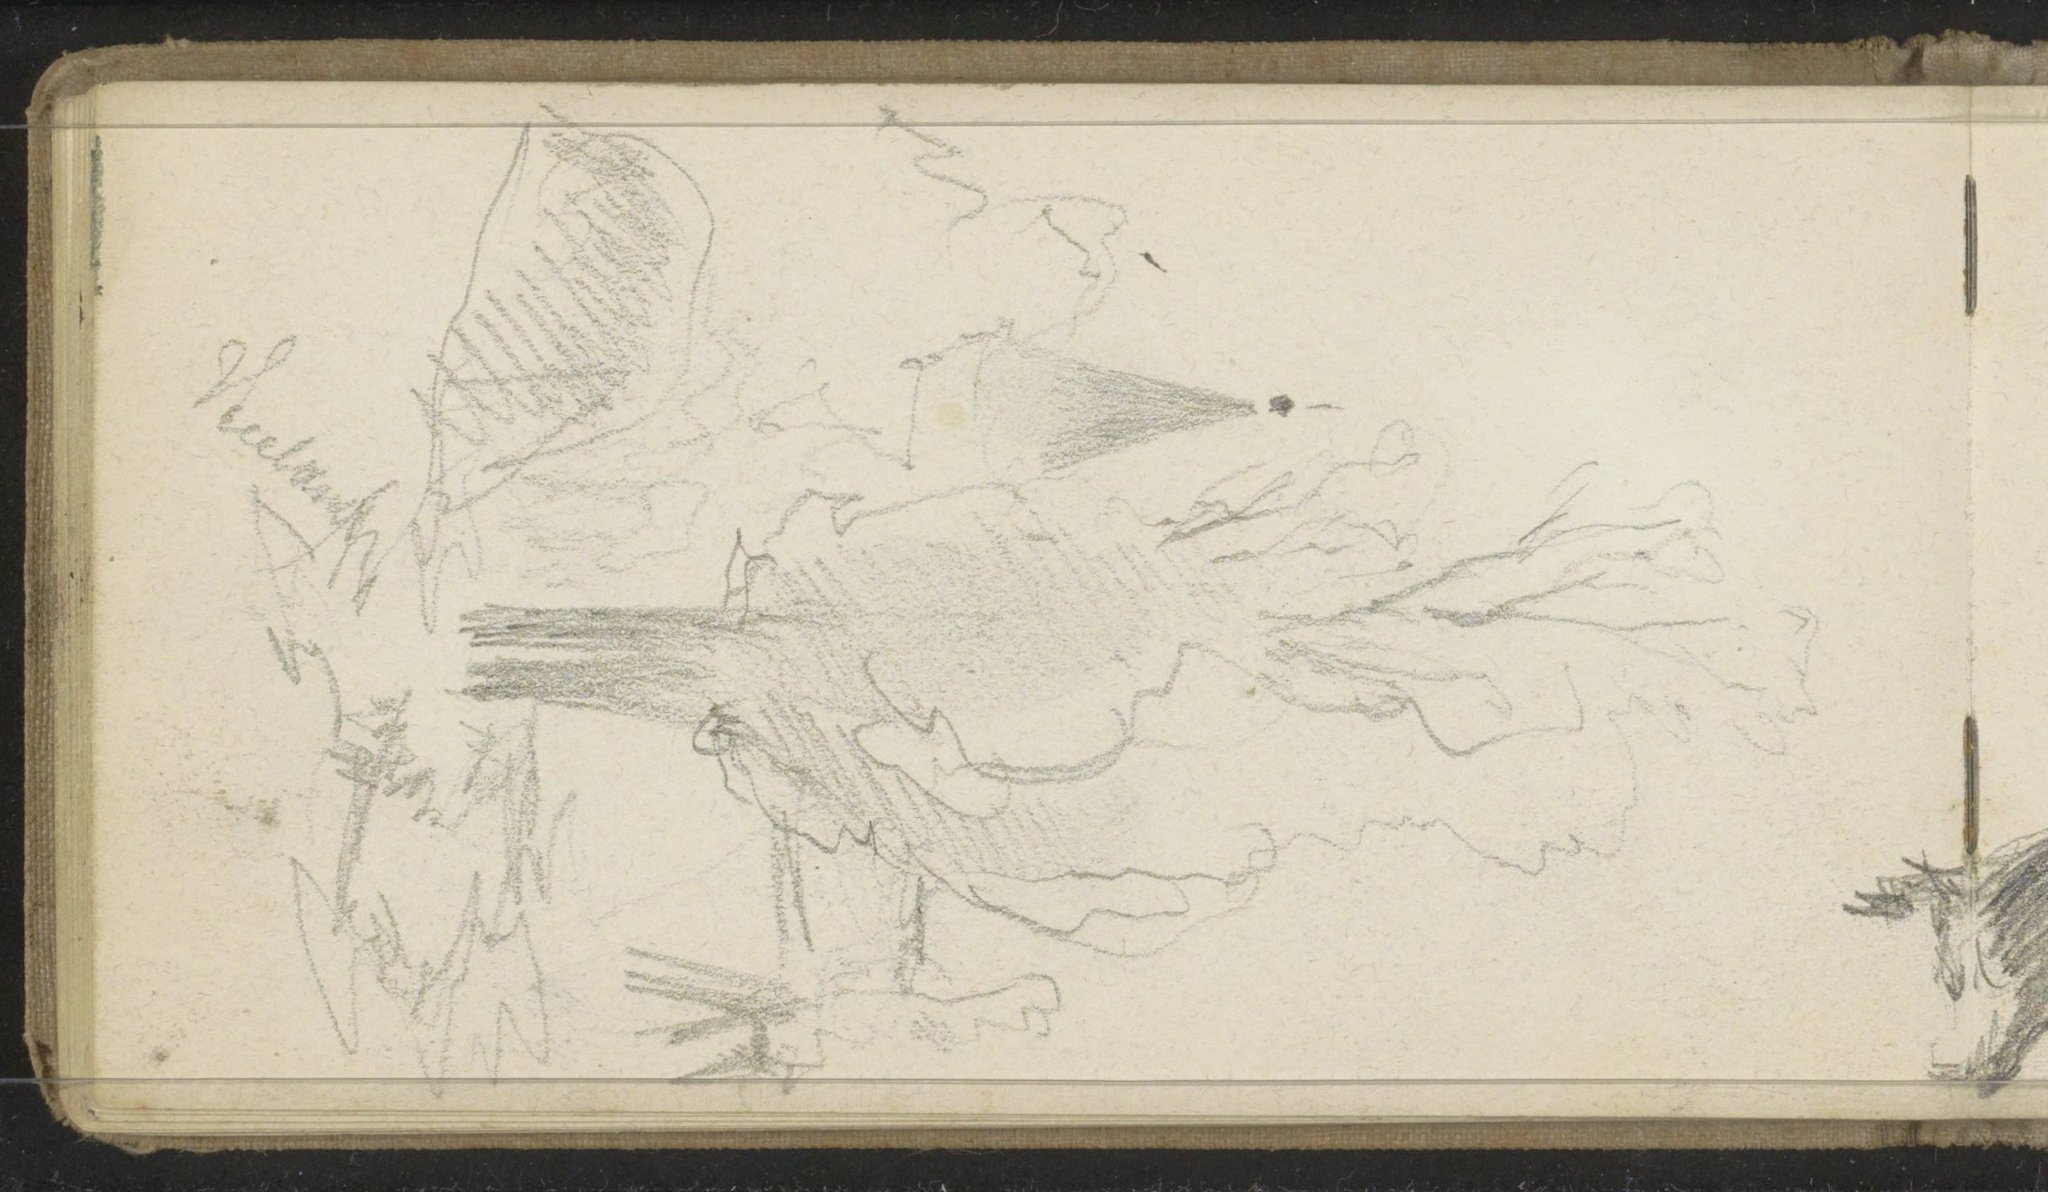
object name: sketchbook leaf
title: Toren van de Hervormde Kerk te Vreeland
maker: willem cornelis rip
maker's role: draughtsman, painter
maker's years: 1856-1922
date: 1895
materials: paper, pencil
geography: vreeland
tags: parts of church exterior and annexes: tower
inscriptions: annotation: ‘Vreeland’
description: Blad 27 verso uit een schetsboek met 39 bladen.